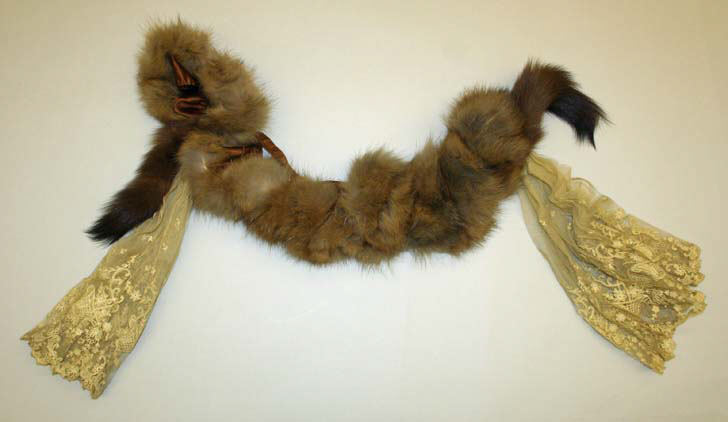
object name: collar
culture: american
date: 1894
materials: fur